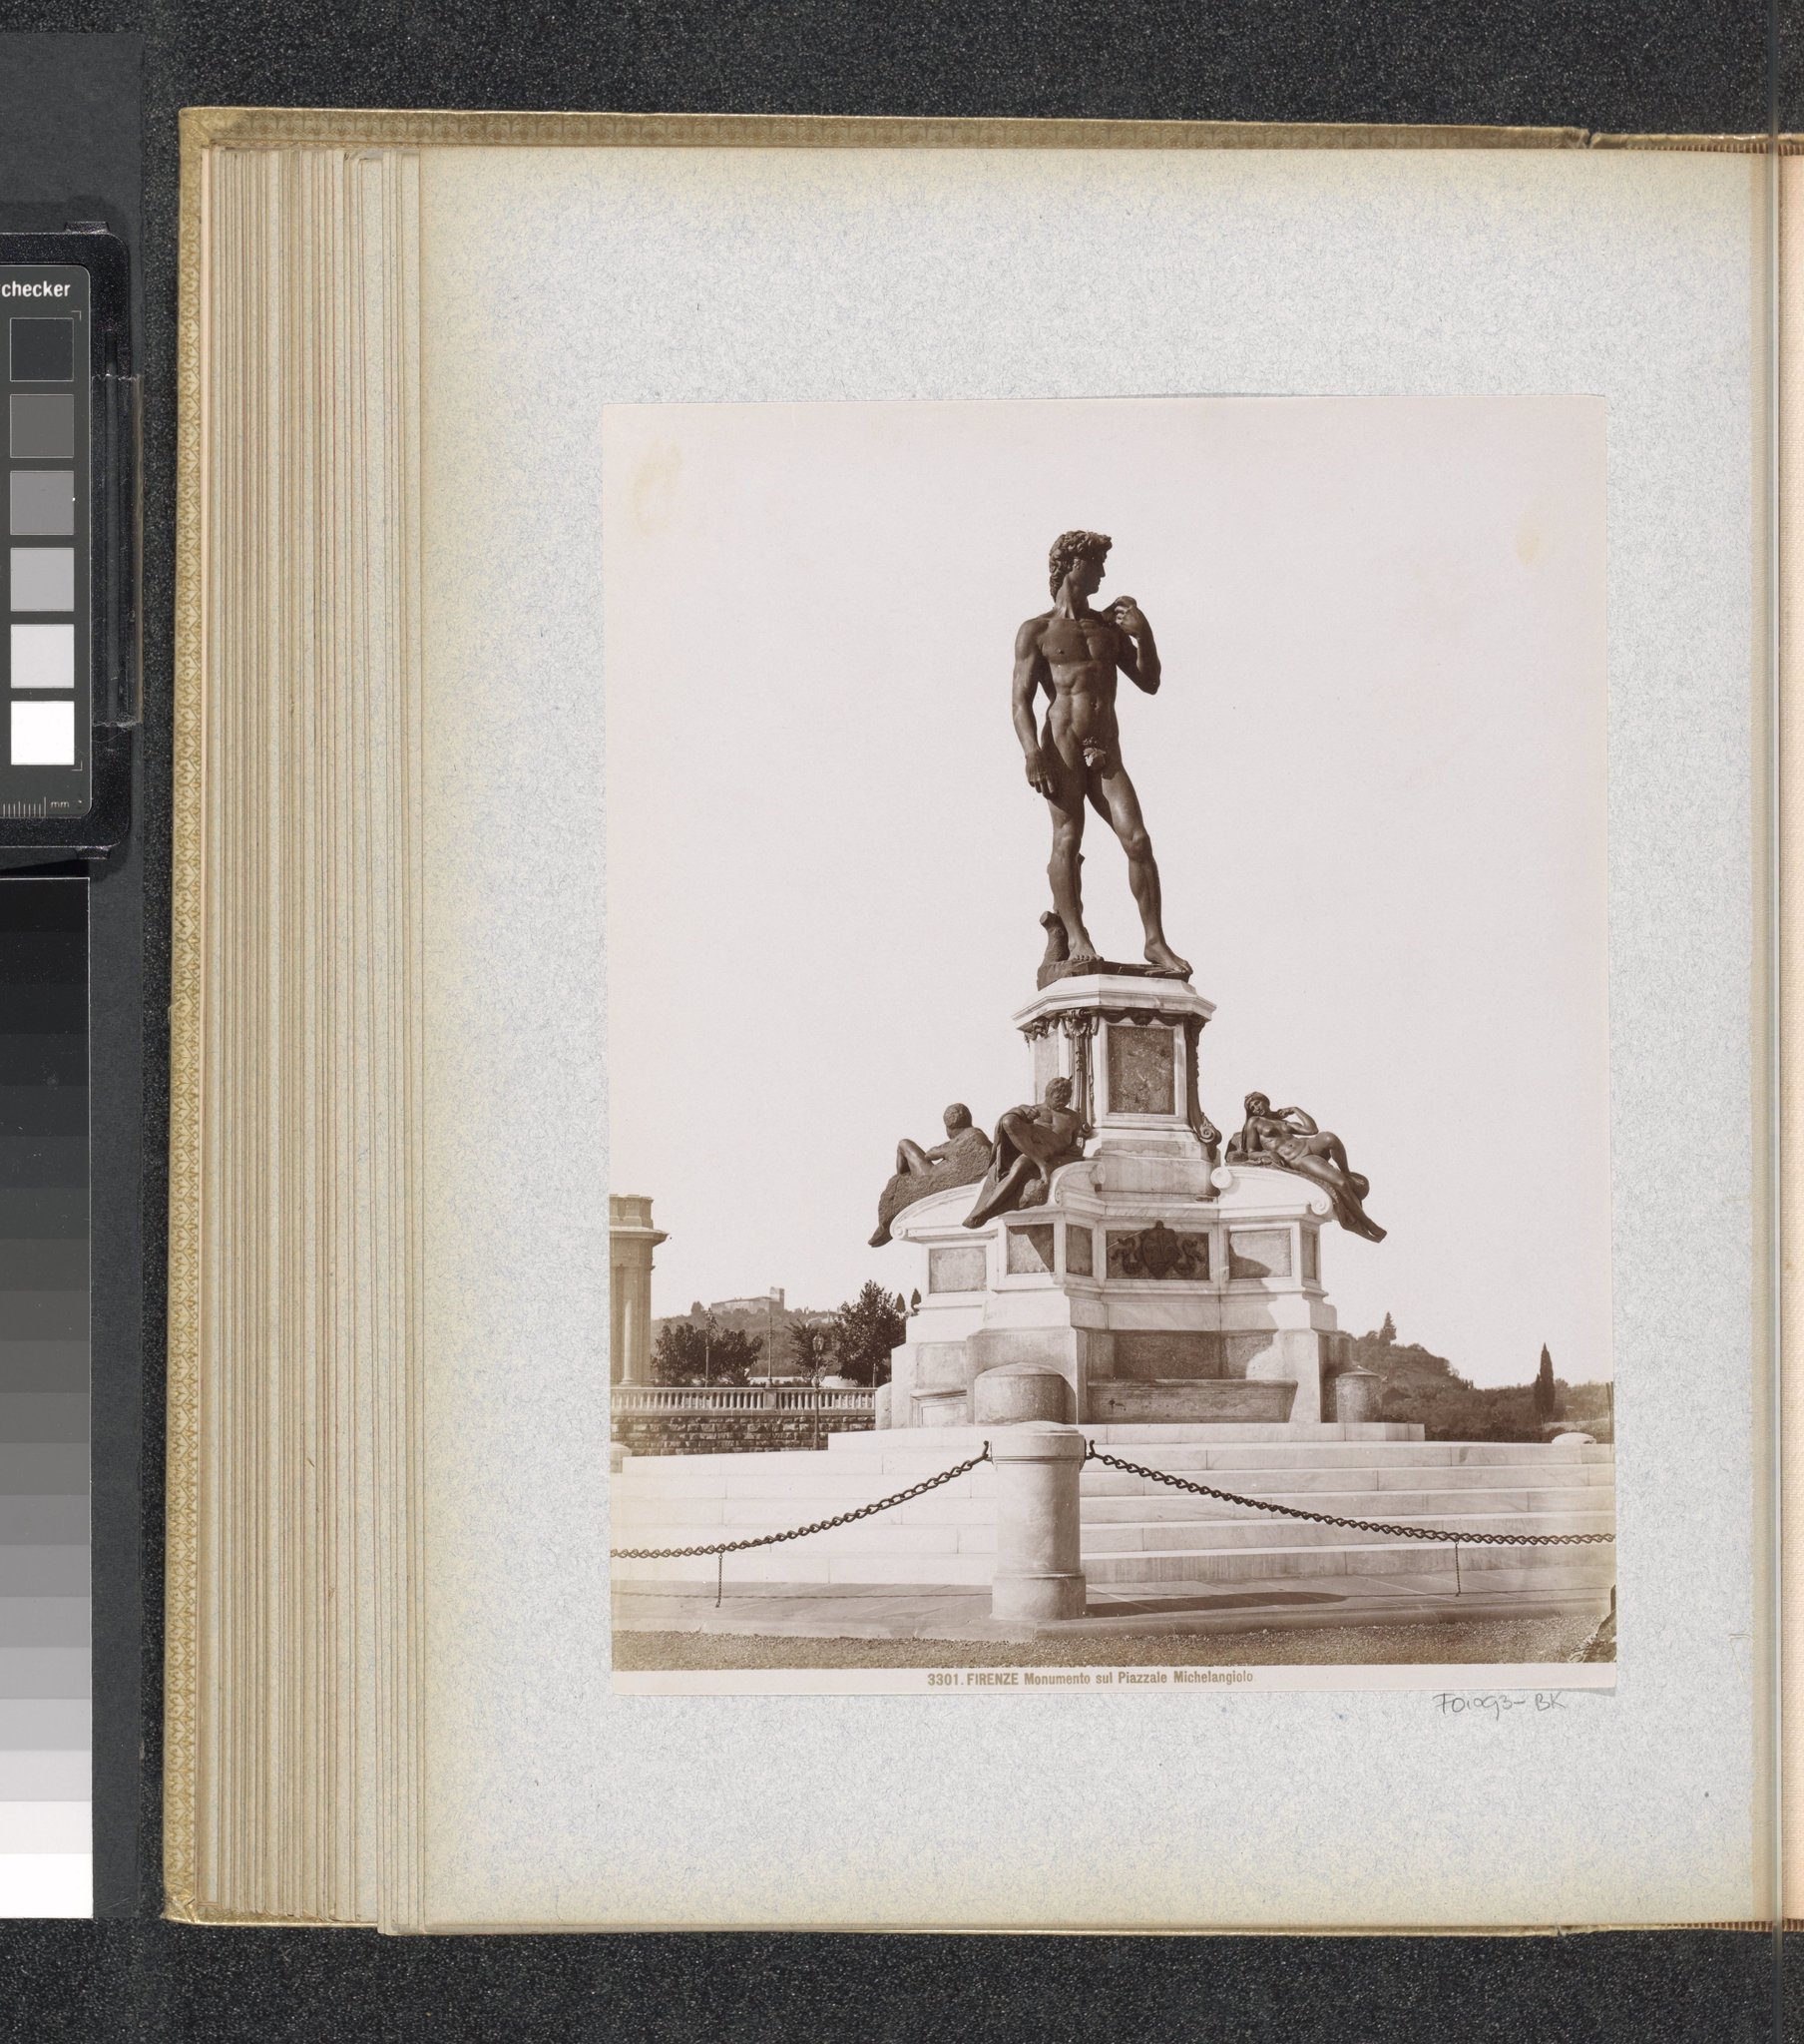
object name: photograph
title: FIRENZE Monumento sul Piazzale Michelangiolo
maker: Anonymous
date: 1870-1890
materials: paper, photographic support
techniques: albumen print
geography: florence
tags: monument, statue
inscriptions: negative number: ‘3301’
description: Onderdeel van Reisalbum met foto's van bezienswaardigheden in Genua, Florence en Venetië.